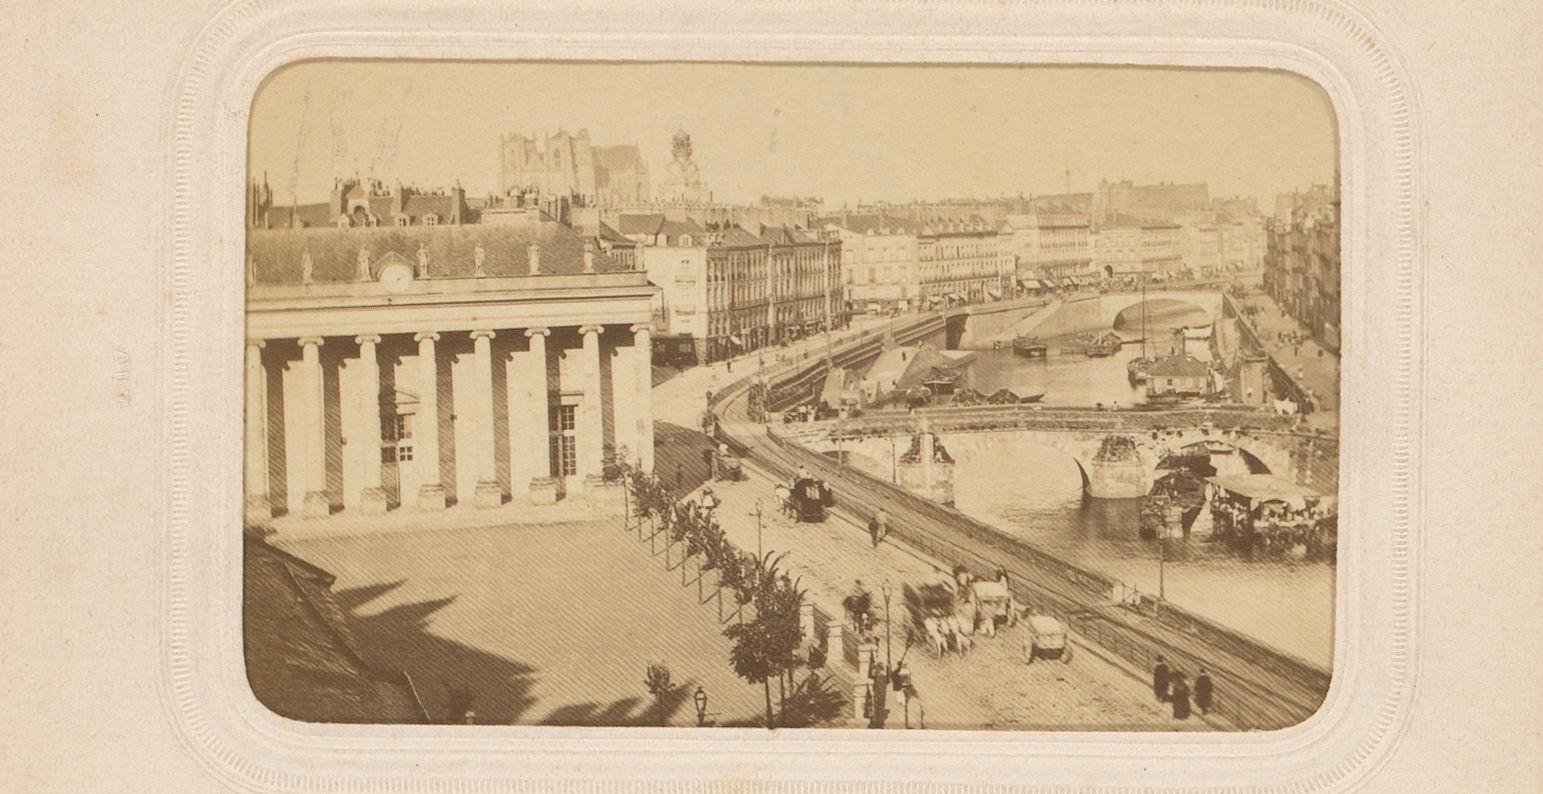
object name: carte de visite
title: Straatgezicht op Nantes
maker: j. trésorier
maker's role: fotograaf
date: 1860-1900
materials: cardboard, photographic support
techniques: albumen print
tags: city-view in general; 'veduta', canals, waters (in city)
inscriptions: inscription: ‘J. Trésorier/ Rue du Chapeau rouge 6/ et Rue Coileau 16 (bis)/ dans le jardin’